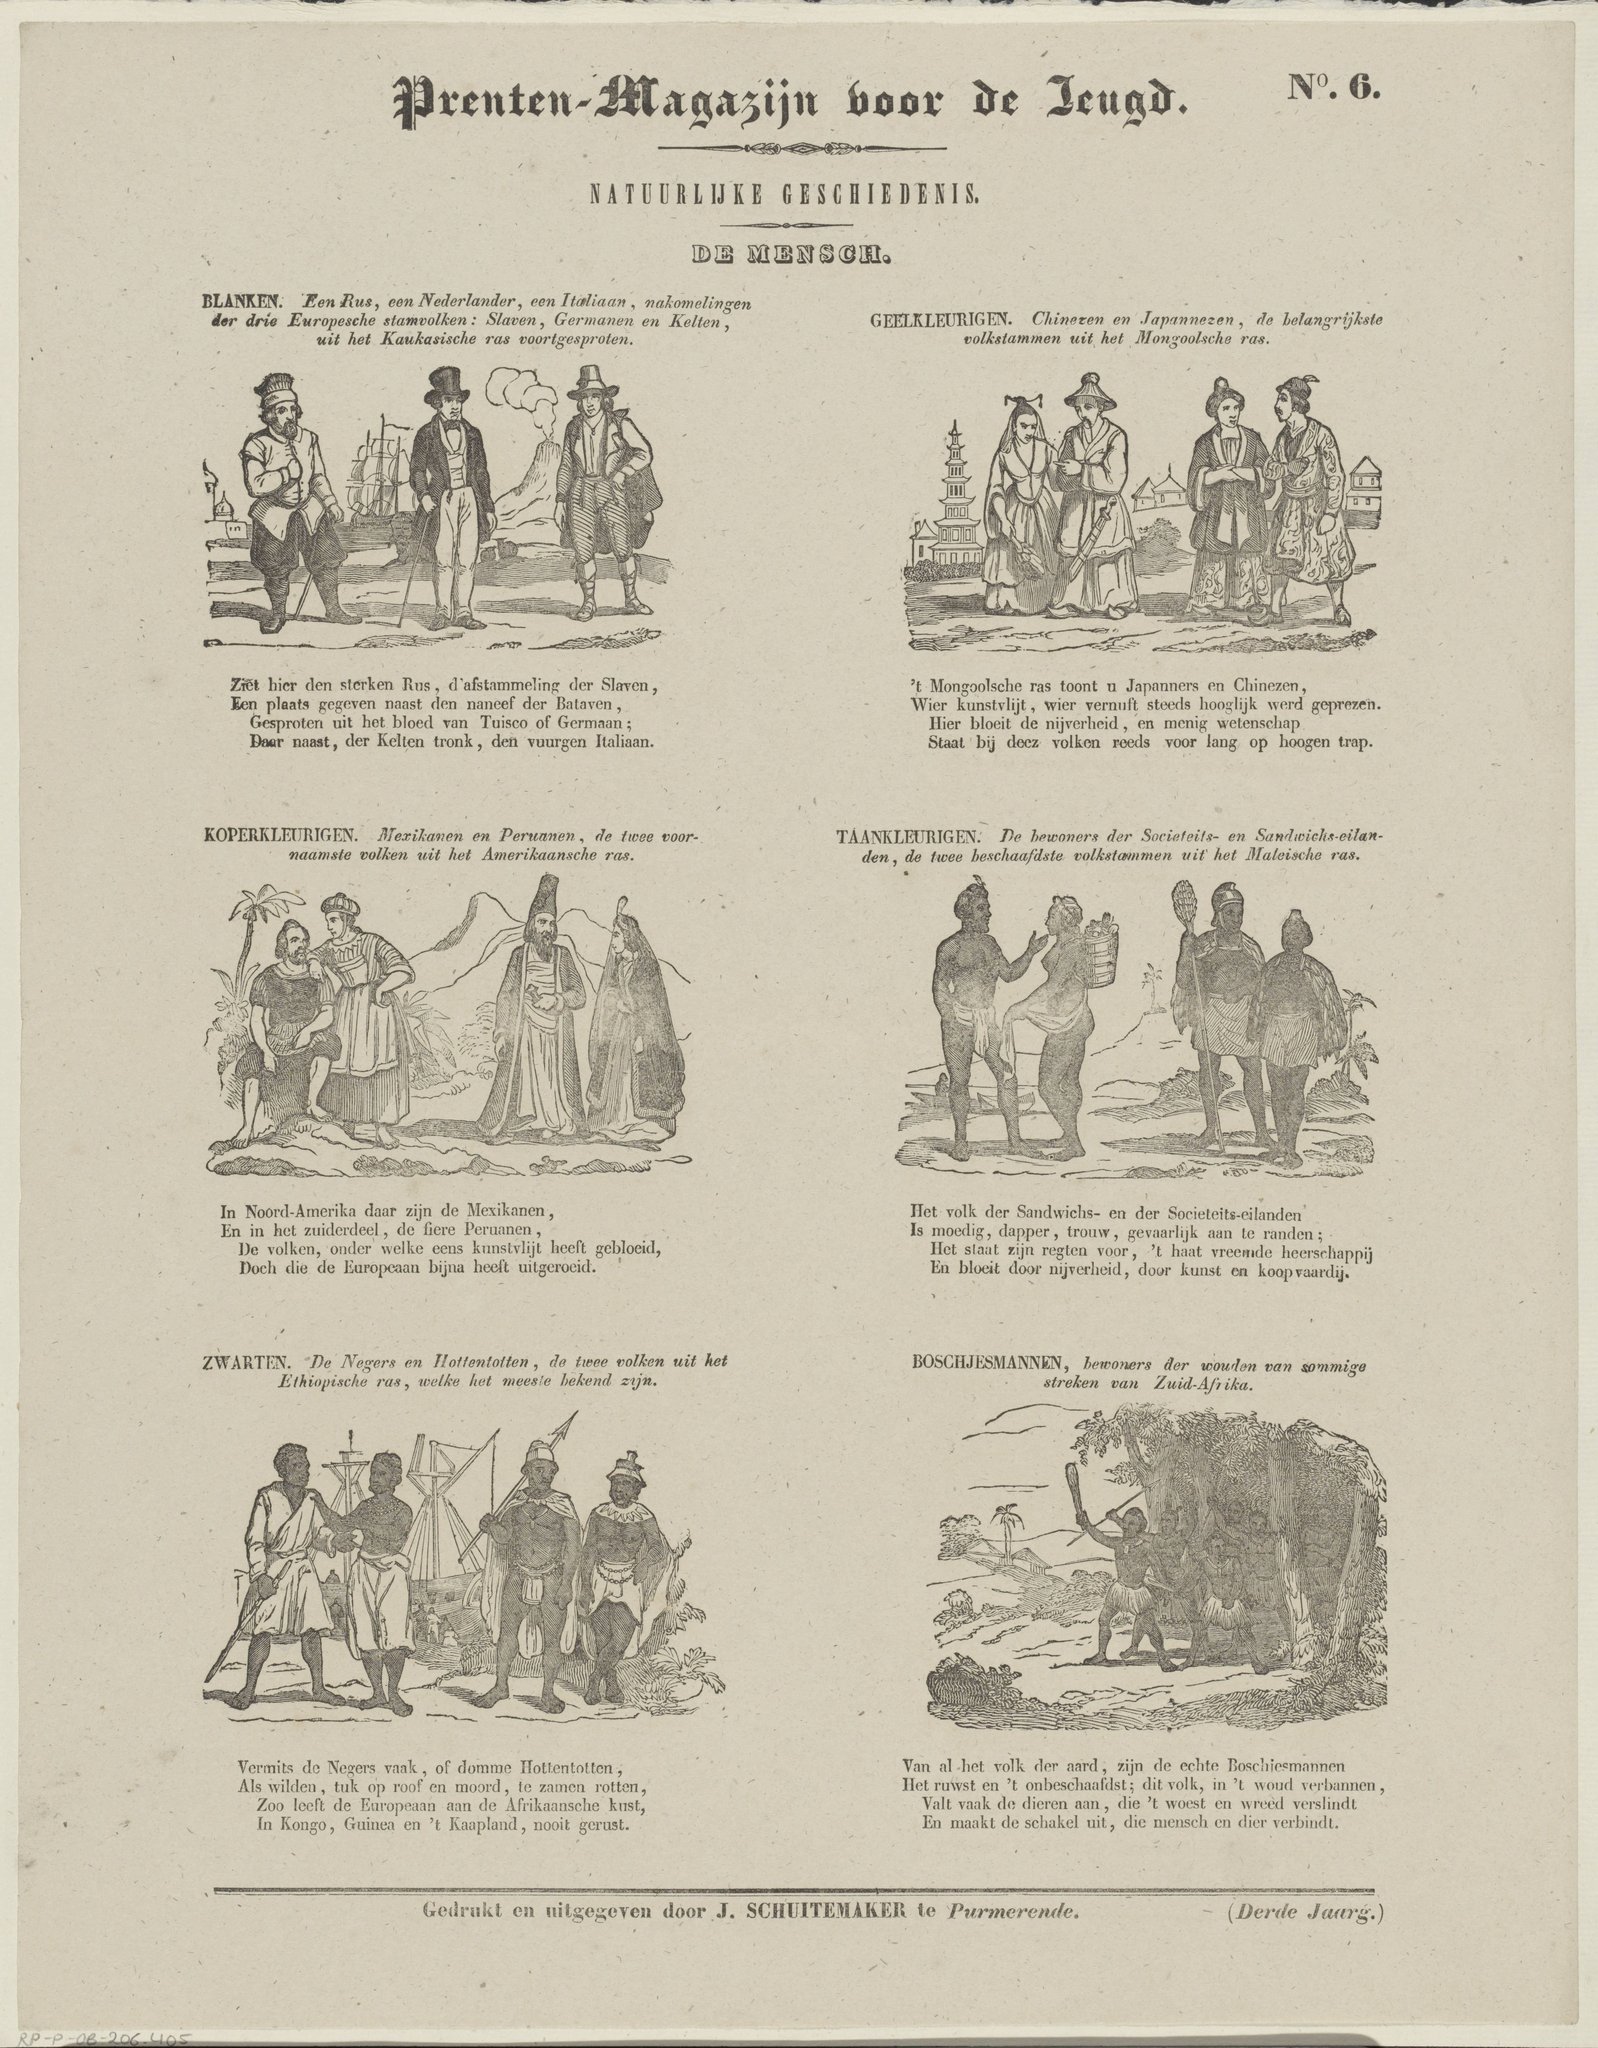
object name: popular print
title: De mensch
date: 1844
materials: paper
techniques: letterpress printing, engraving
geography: purmerend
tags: europeans, asiatic races and peoples, africans, indigenous peoples of south america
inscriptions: collector's mark: Lugt 2760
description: Blad met 6 voorstellingen van verschillende rassen en volkeren. Boven elke voorstelling een titel en onder elke voorstelling een vierregelig vers. Genummerd rechtsboven: No. 6.